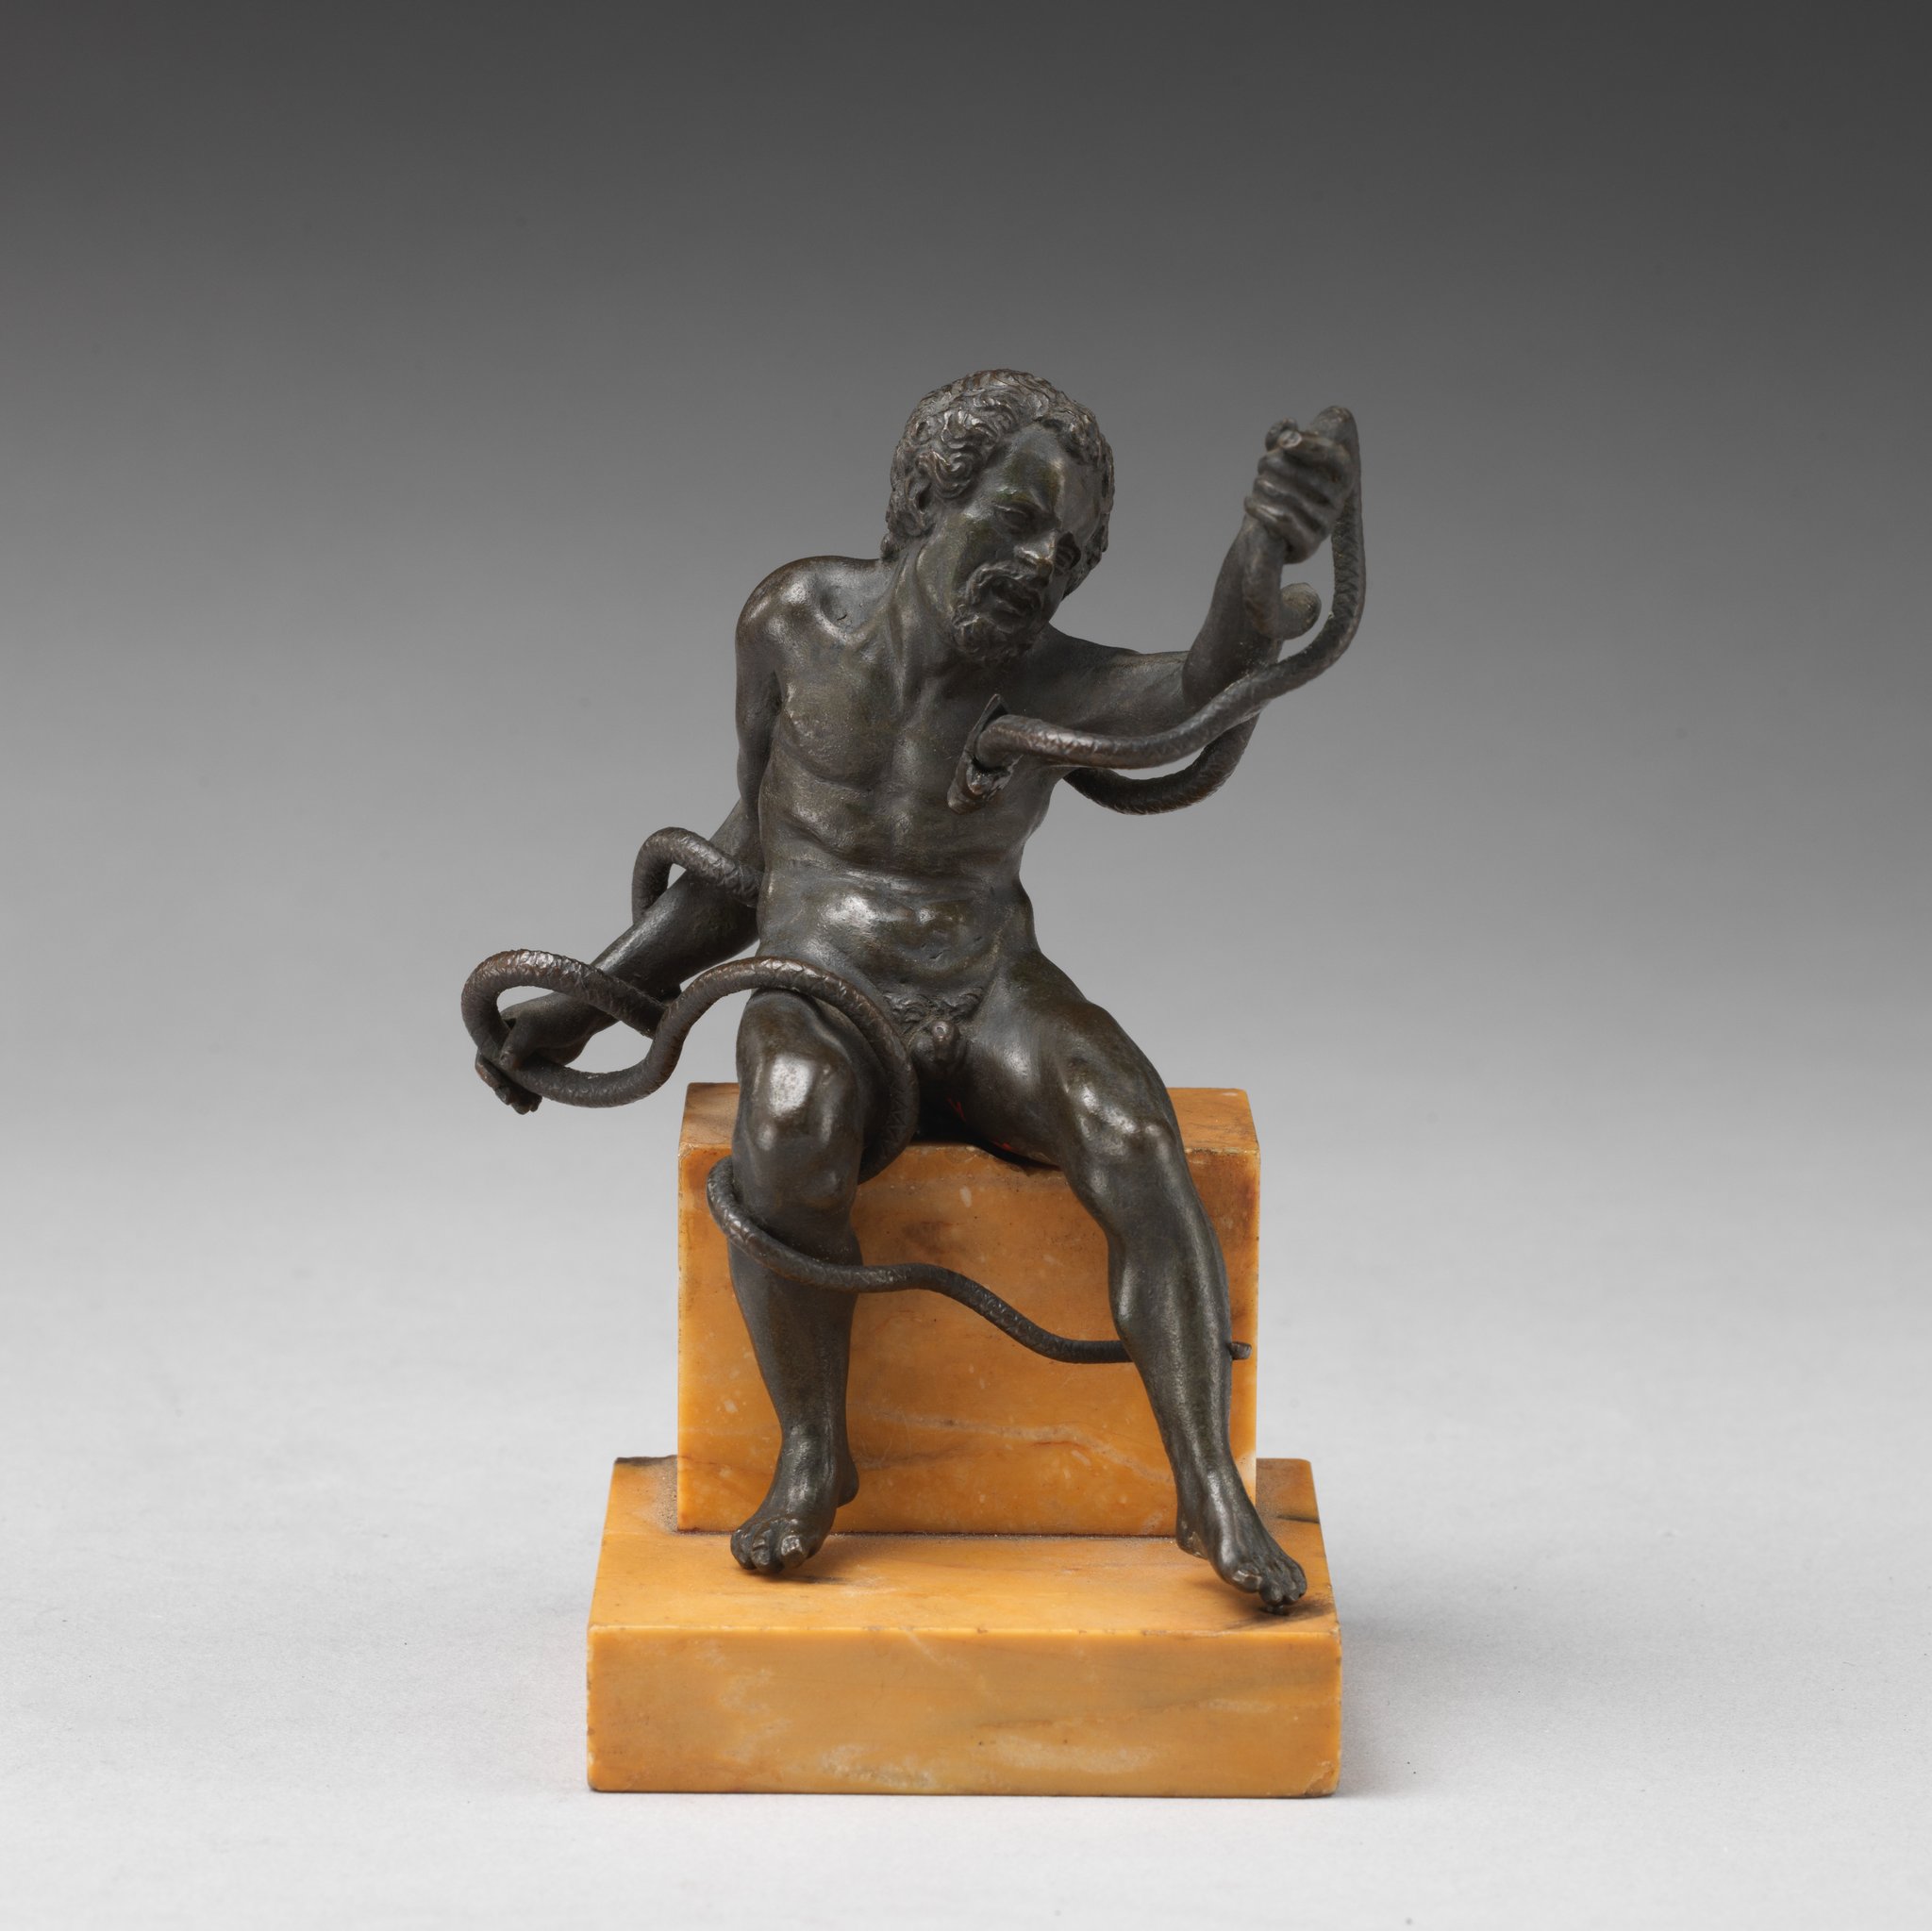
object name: statuette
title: Man Struggling with a Serpent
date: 1501-1533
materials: bronze, marble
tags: men,serpents